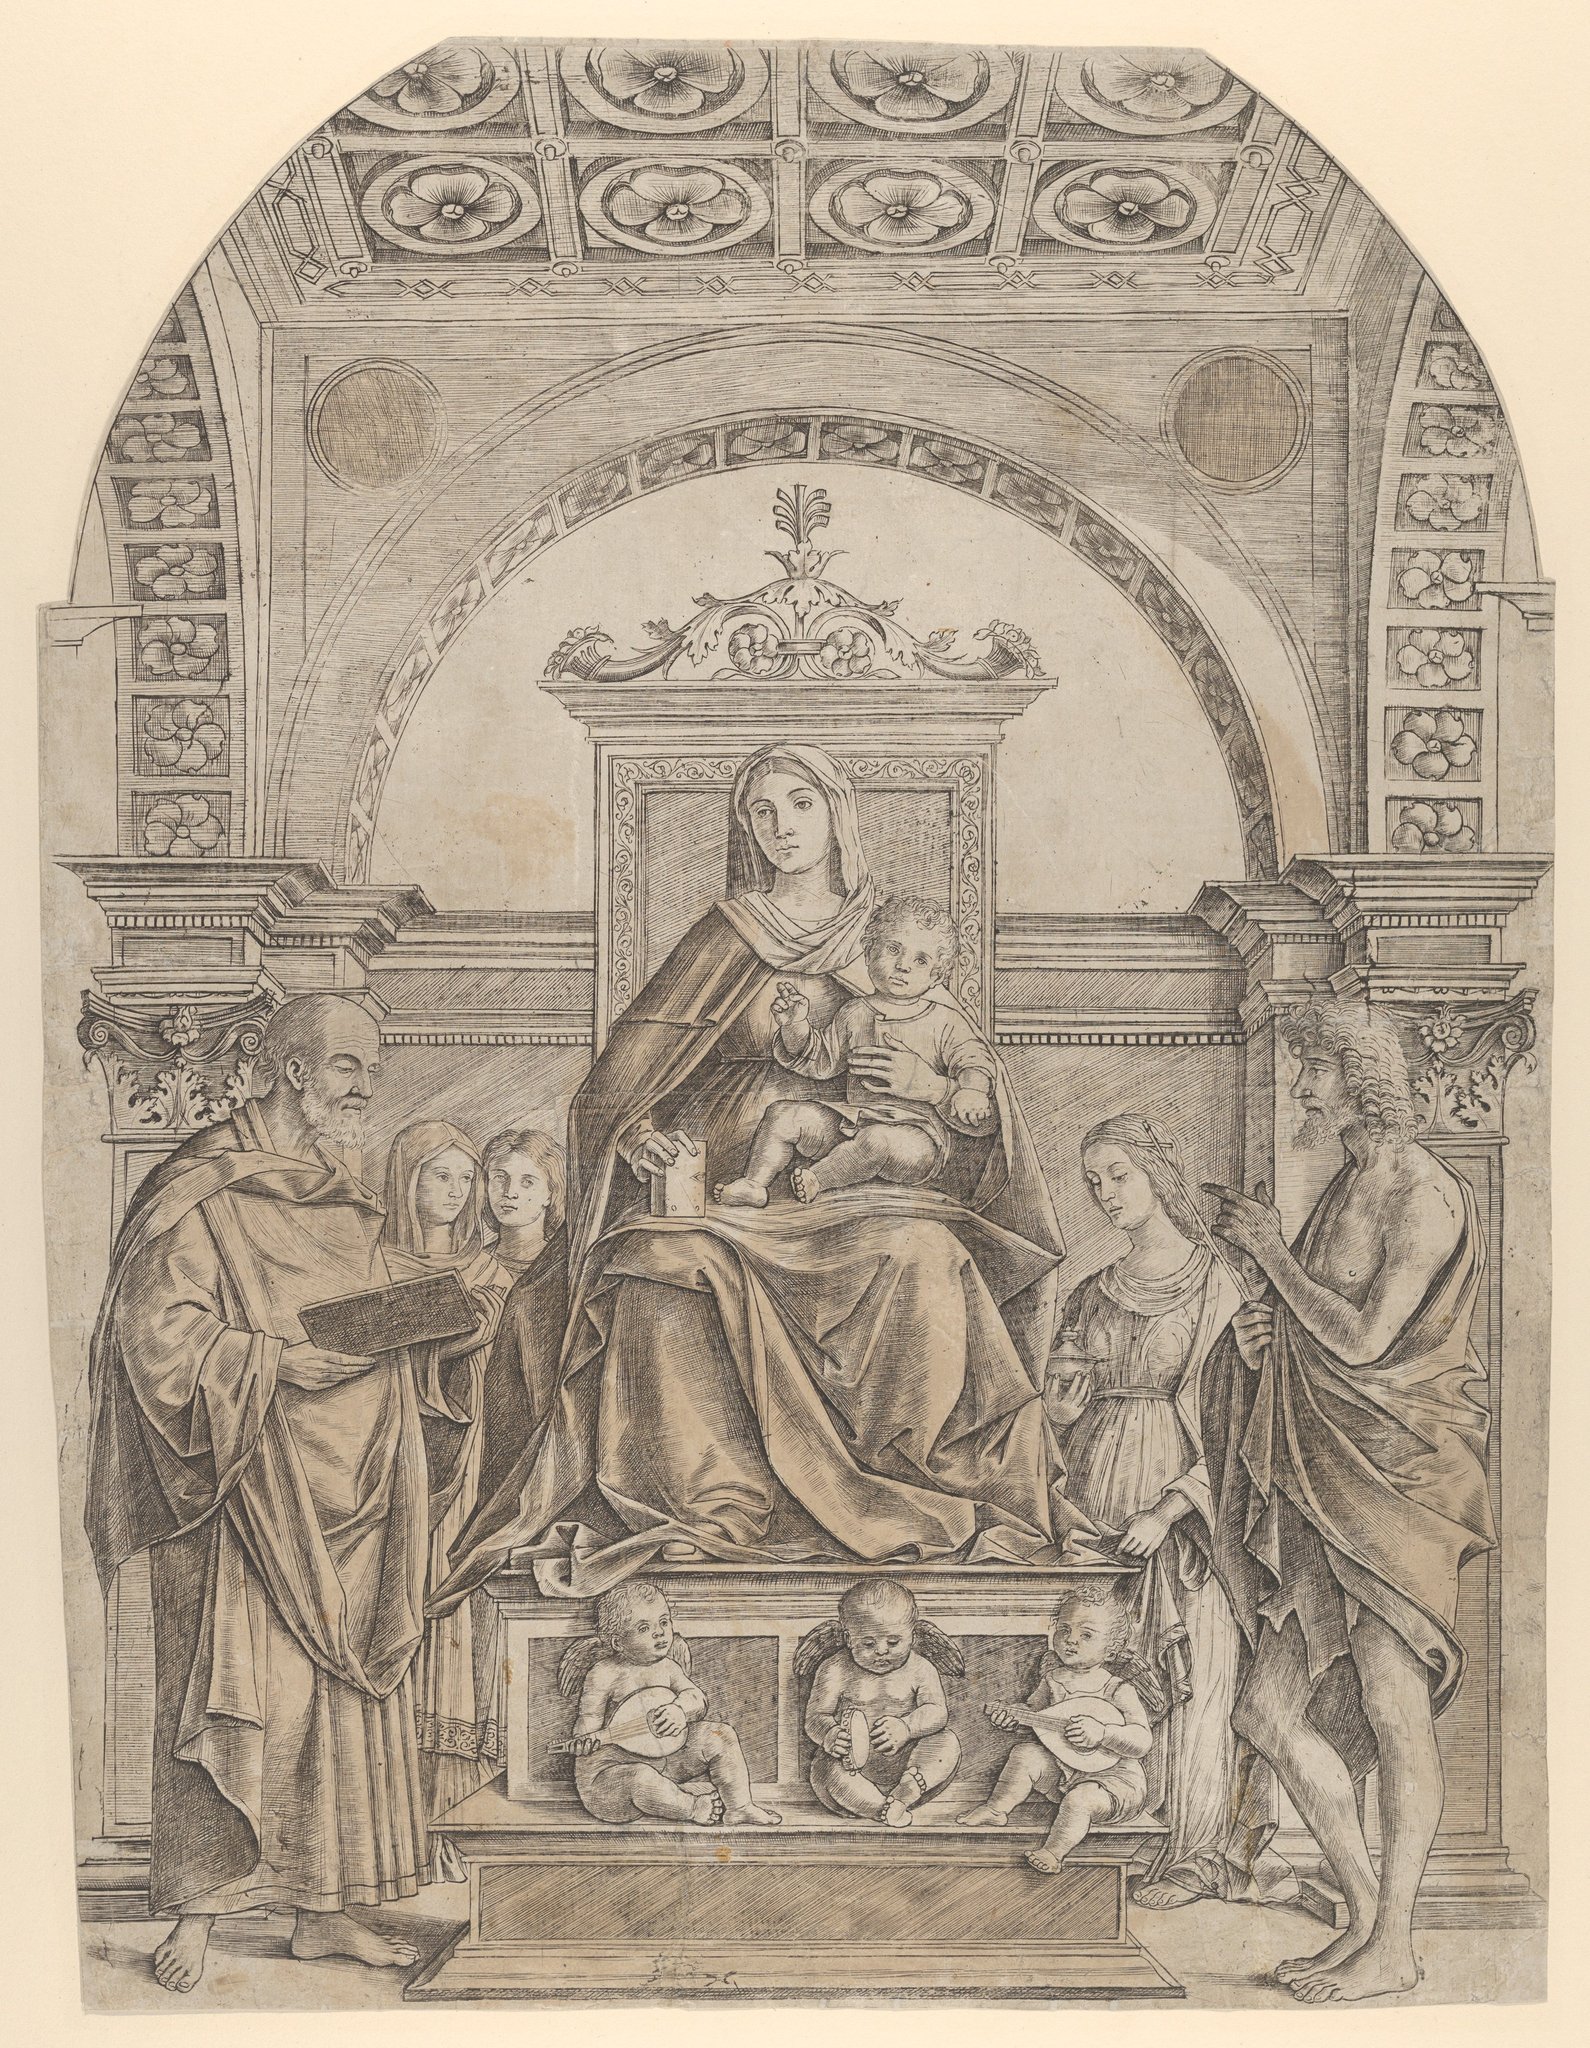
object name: print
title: The Virgin and Child enthroned surrounded by saints and angels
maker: girolamo mocetto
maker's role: artist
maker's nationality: italian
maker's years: 1470-1531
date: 1490-1530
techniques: engraving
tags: angels,madonna and child,saints